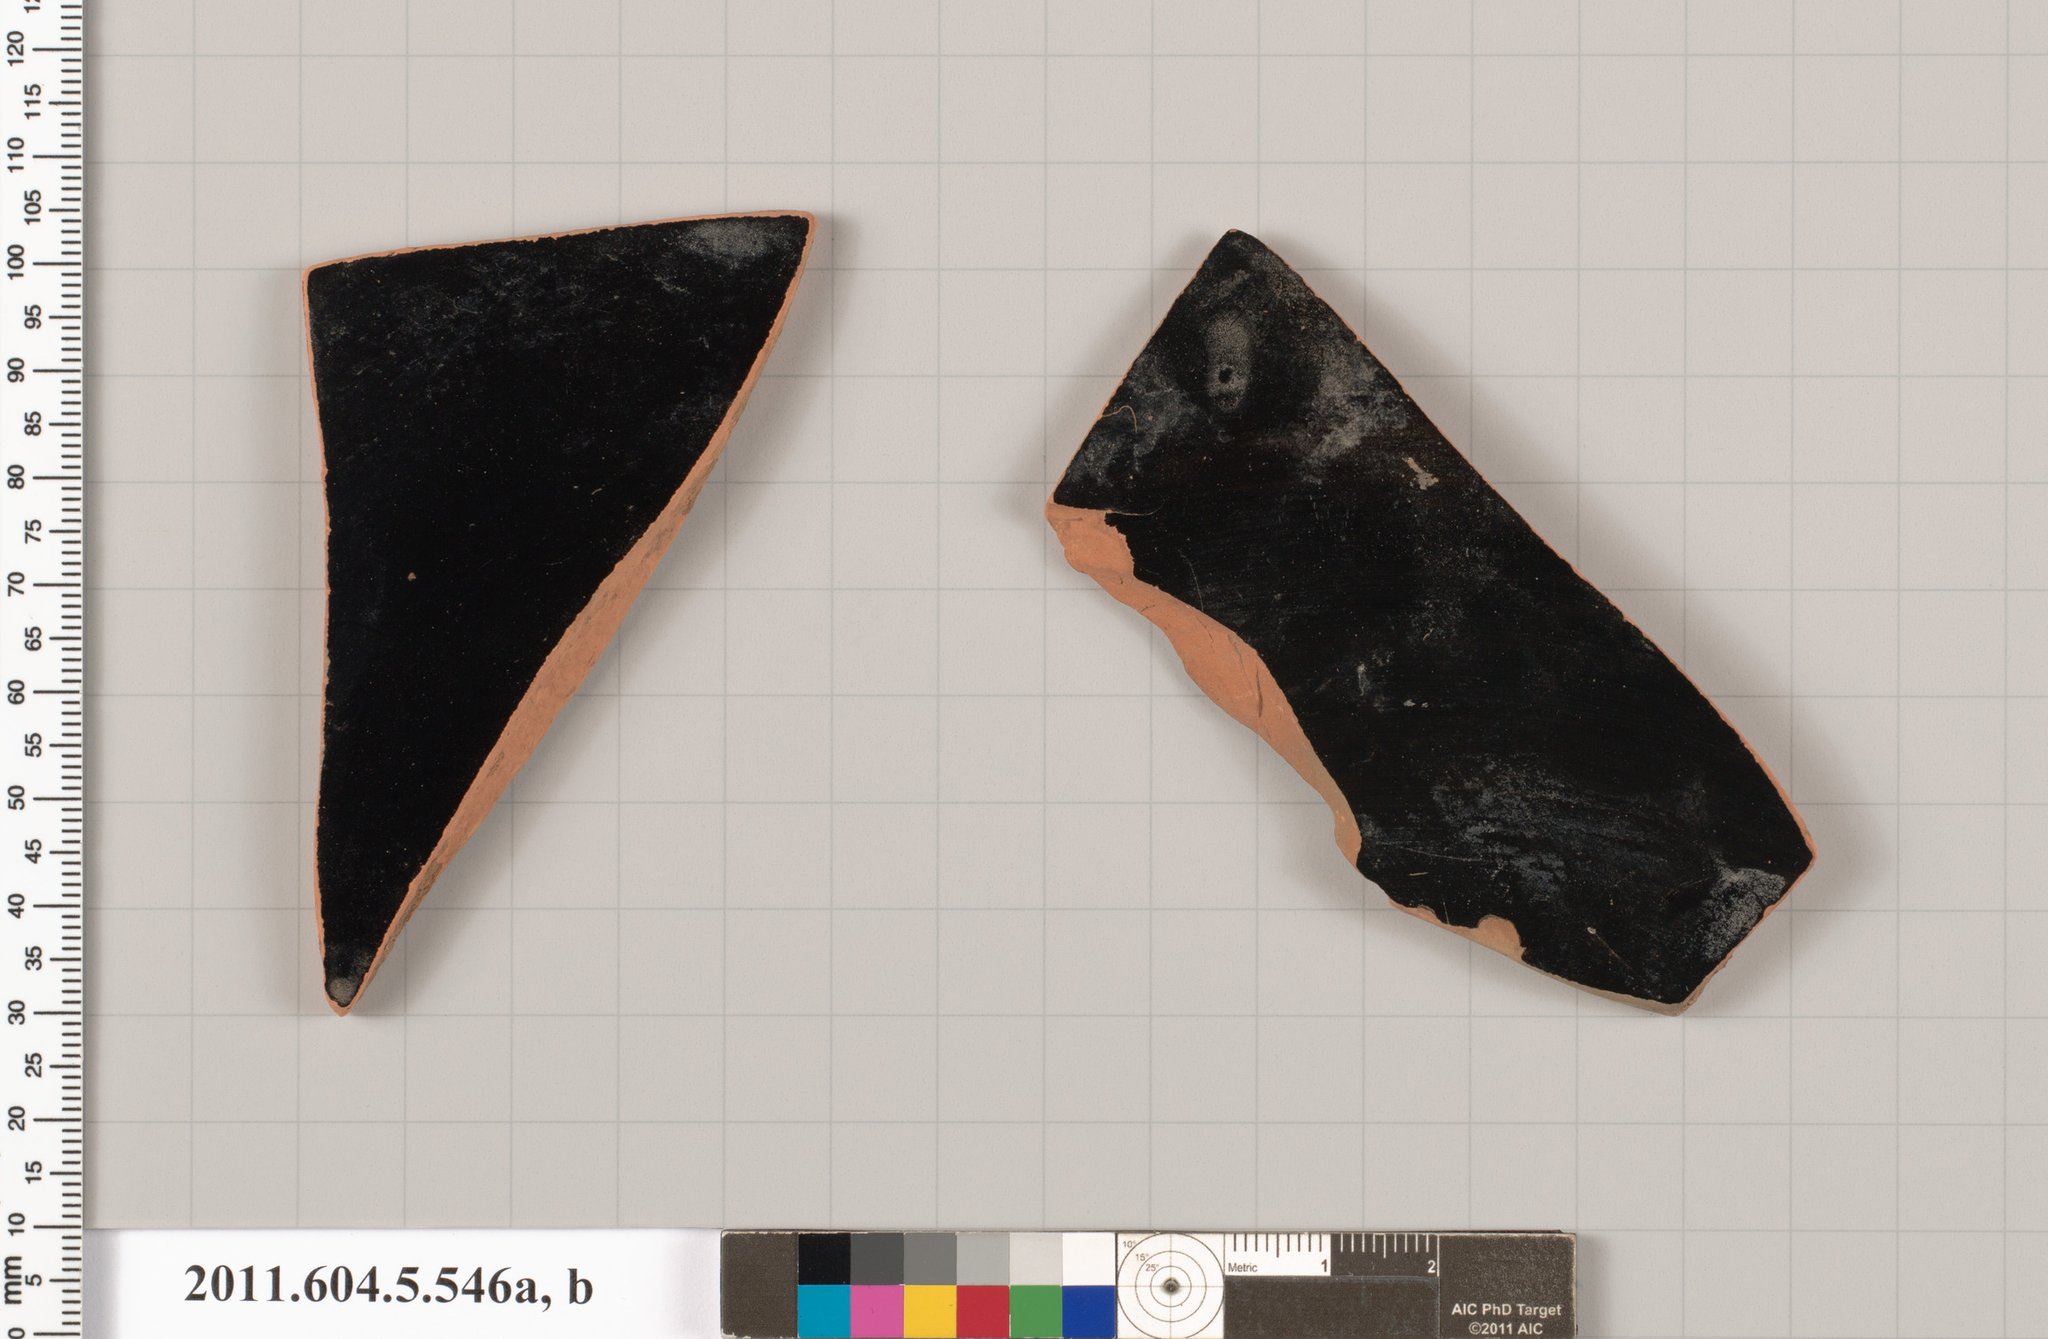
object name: kylix fragment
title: Terracotta fragments of a kylix (drinking cup)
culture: greek, attic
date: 600-401 BCE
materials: terracotta